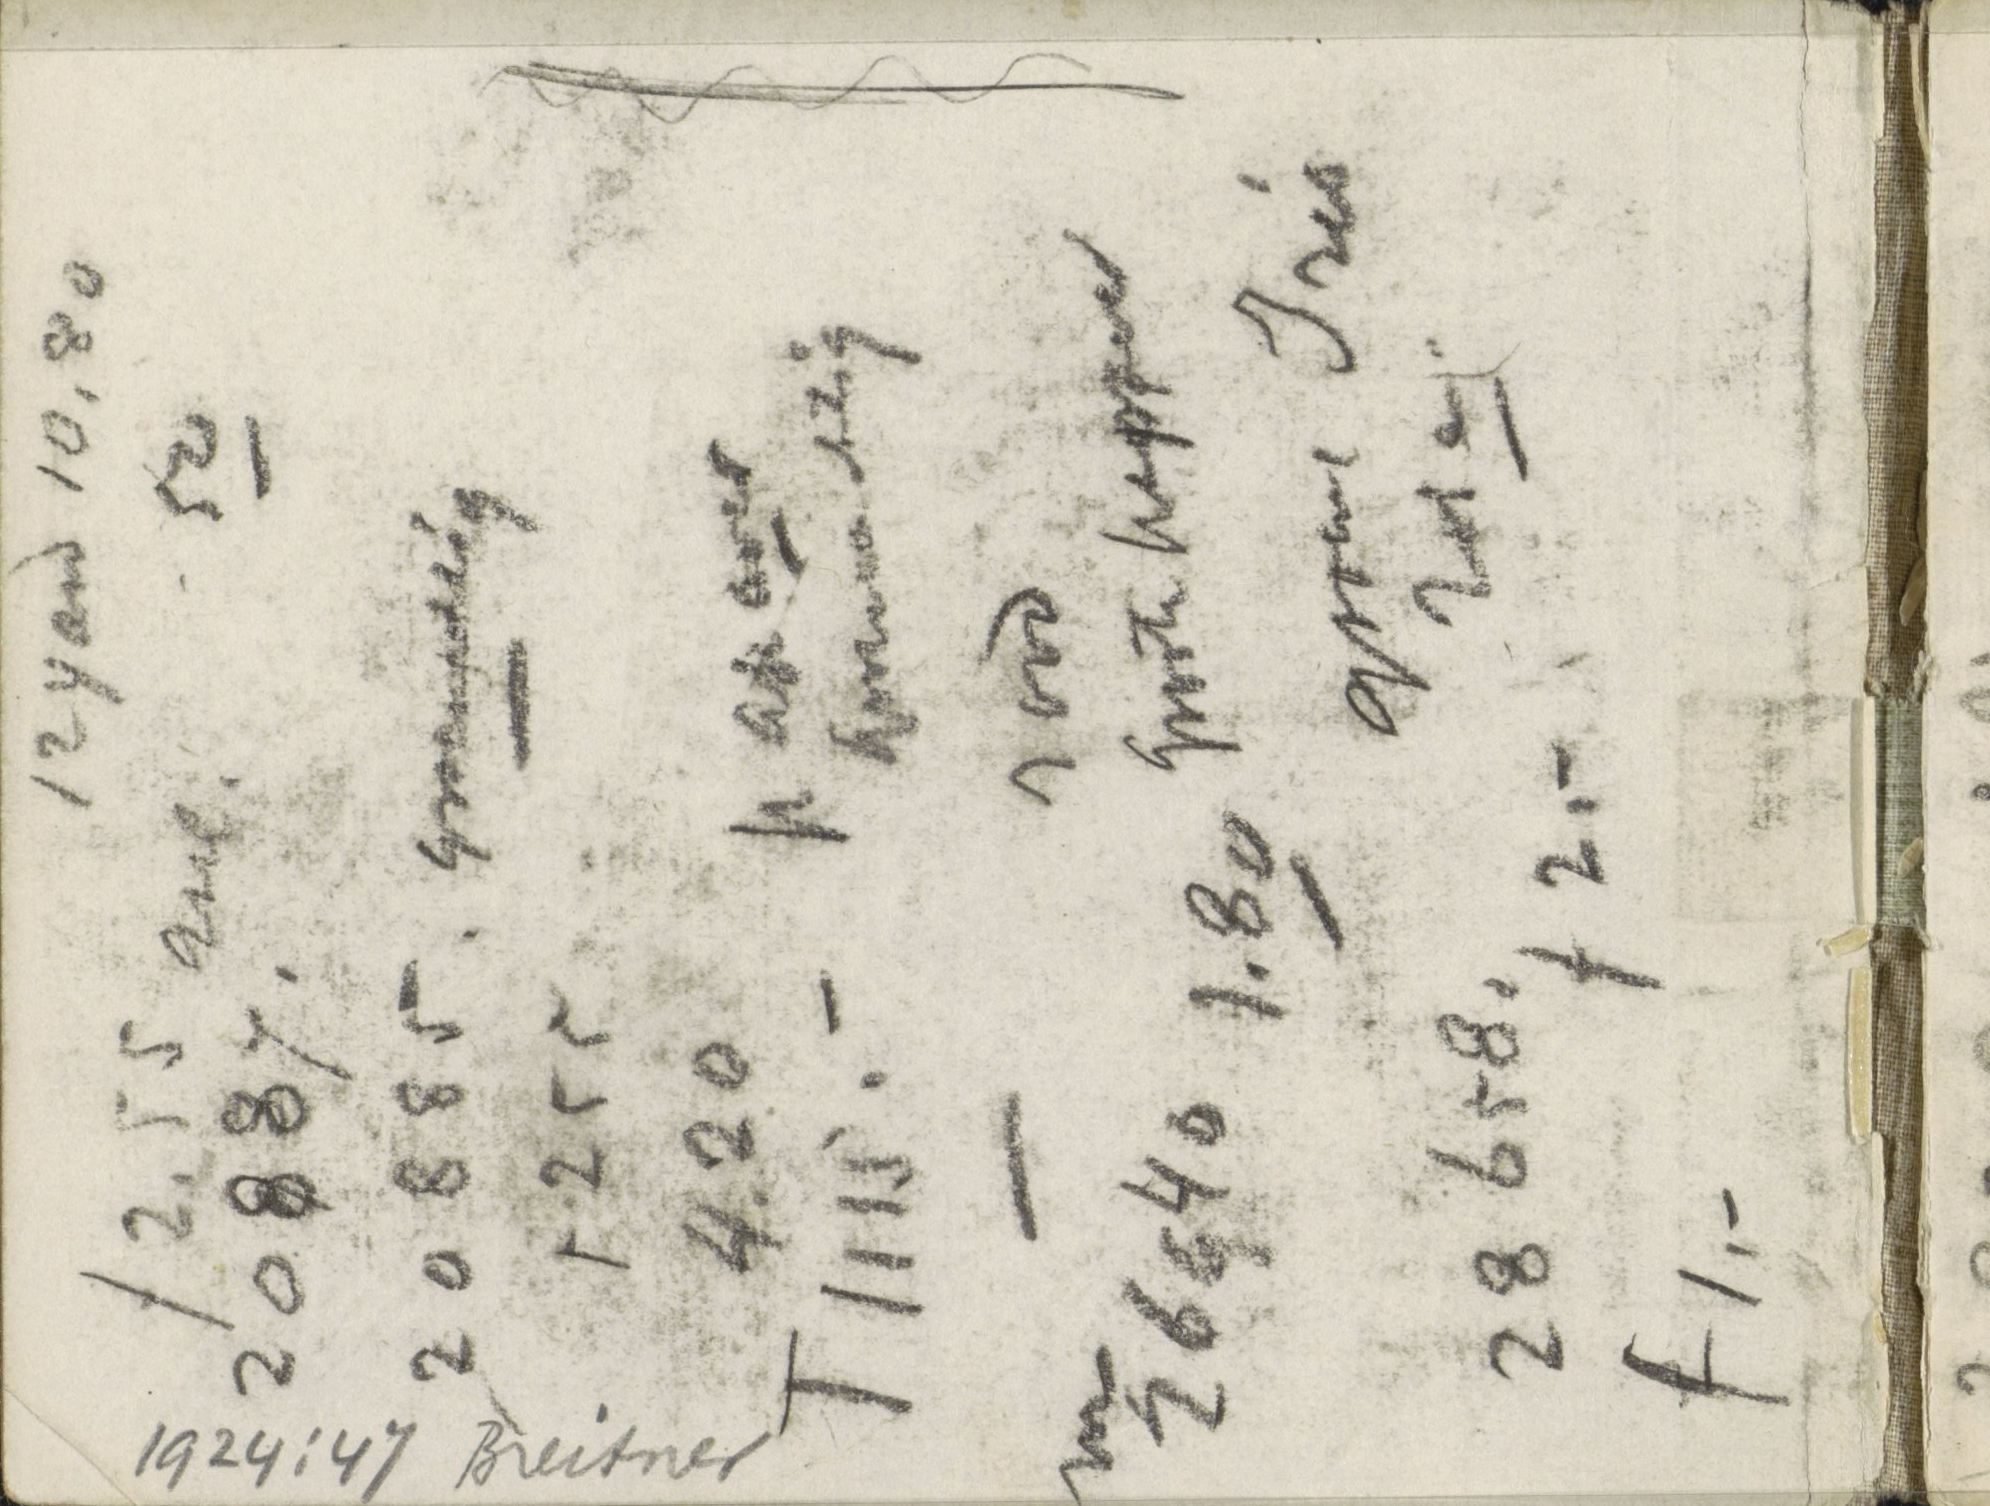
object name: sketchbook leaf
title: Annotaties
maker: george hendrik breitner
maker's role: draughtsman, painter, print maker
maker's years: 1857-1923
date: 1893-1899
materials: chalk, paper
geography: amsterdam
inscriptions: annotation: ‘[...]’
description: Pagina 1, voorste schutblad, uit een schetsboek met 28 bladen.